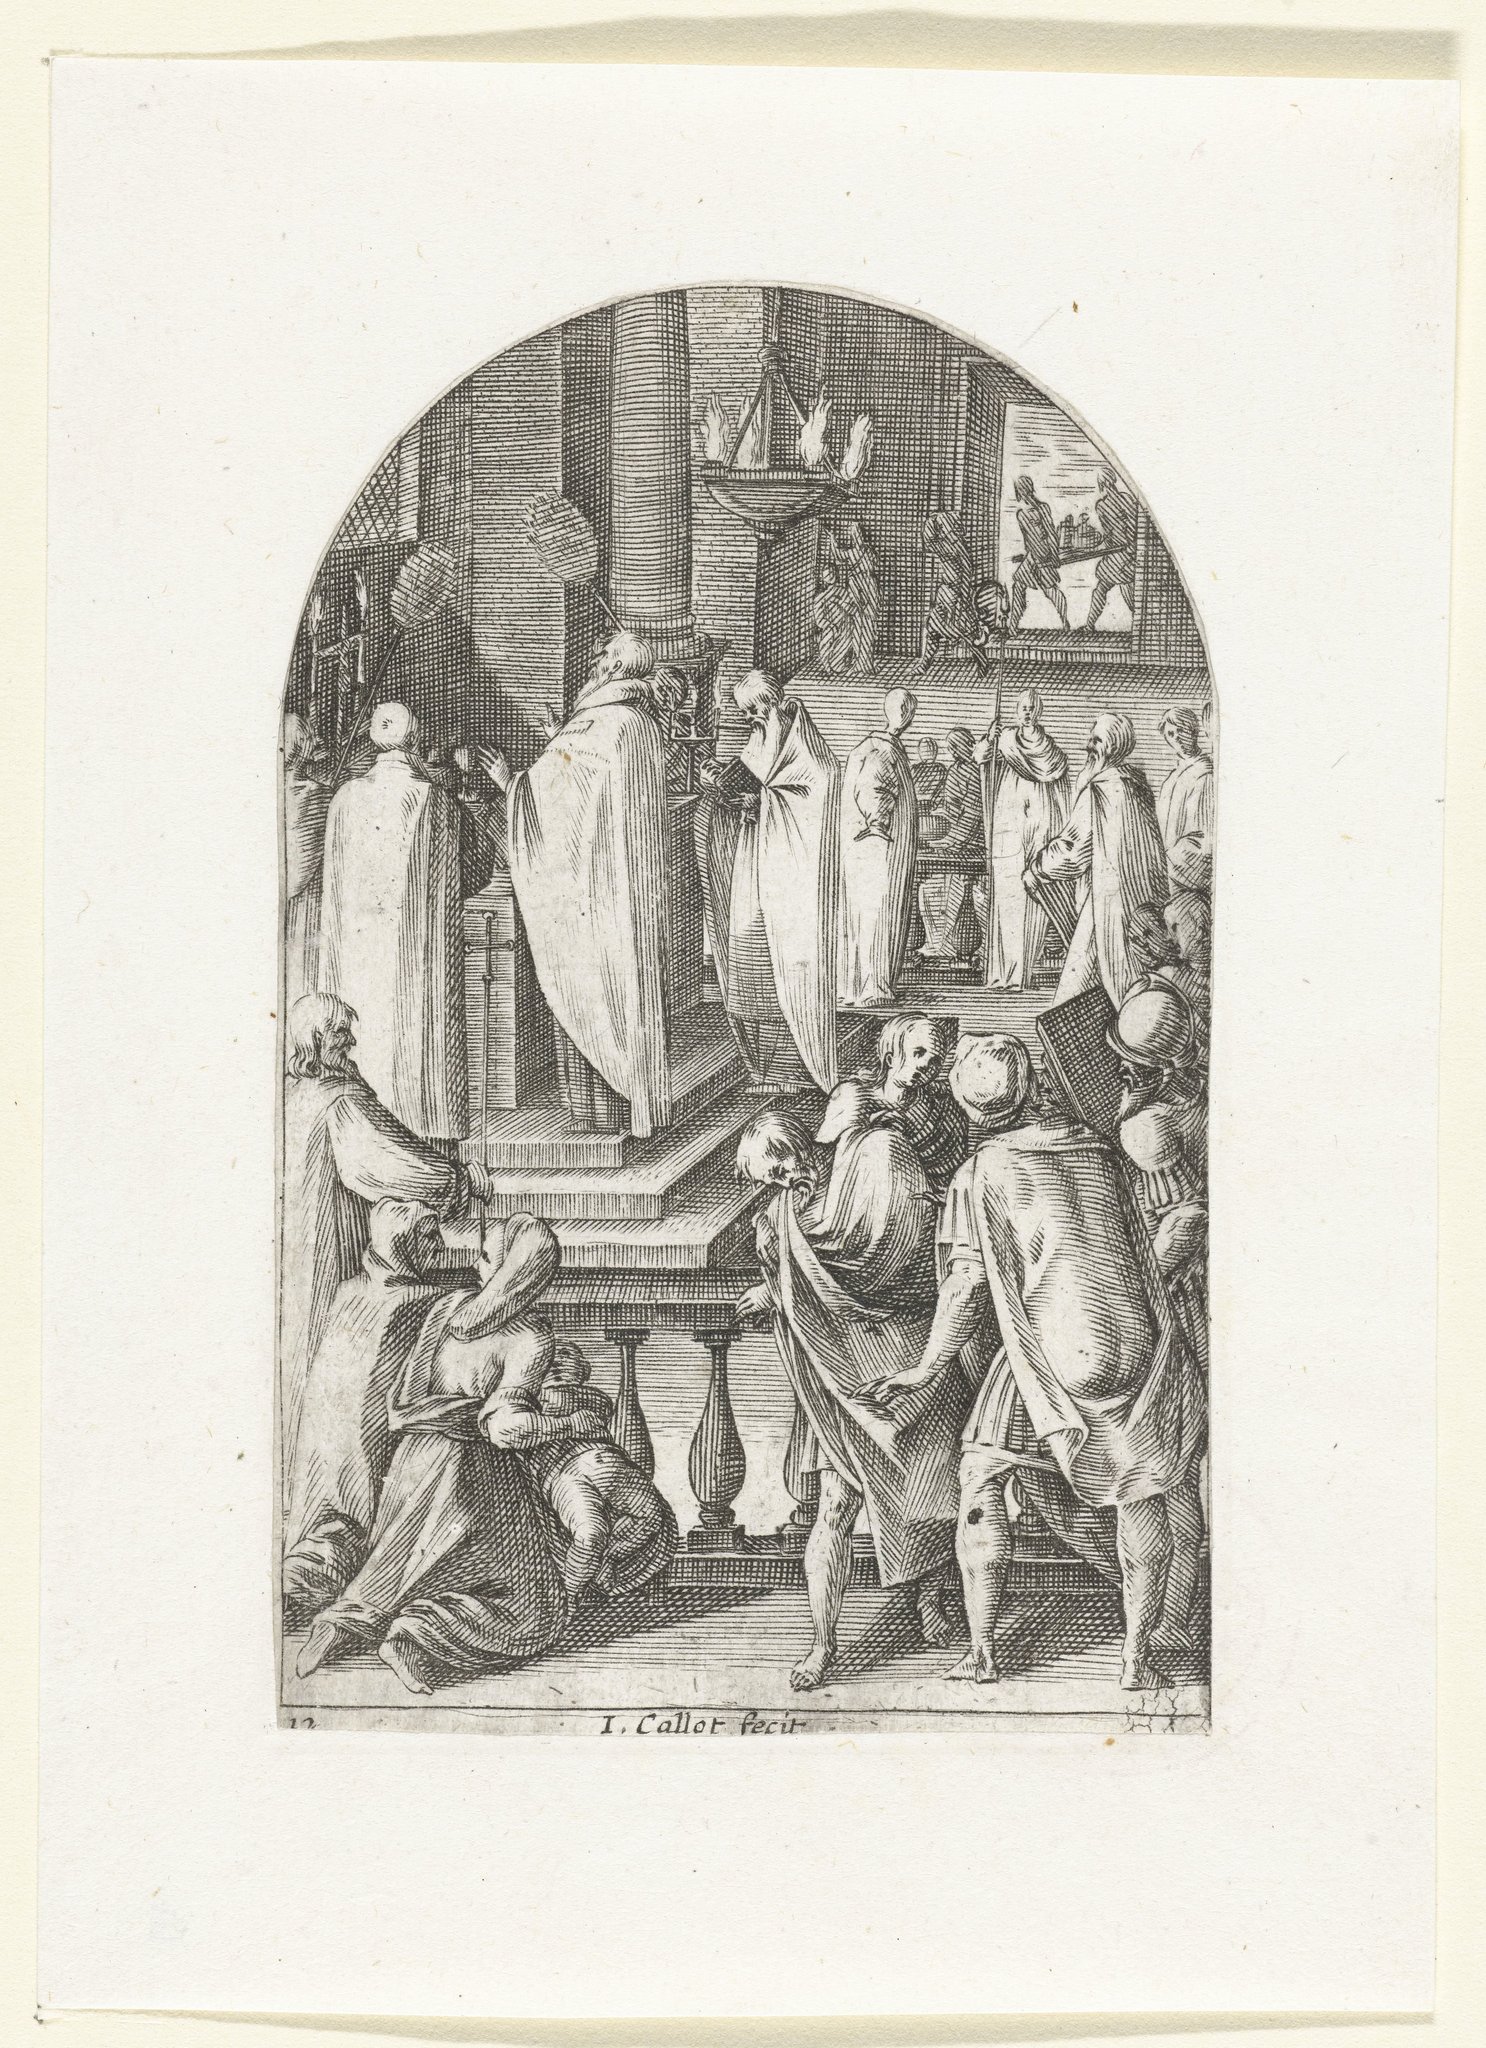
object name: print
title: De viering van de mis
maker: jacques callot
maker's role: draughtsman, print maker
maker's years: 1592-1635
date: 1608-1611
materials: paper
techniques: engraving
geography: rome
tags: the mass of st. basil: emperor valens faints, the mass of st. clement: theodora, wife of the heathen sisinnius present; sisinnius, who is spying, is struck blind, holy mass (divine service, especially of roman catholic church)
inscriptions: collector's mark: Lugt 240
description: Een priester (Heilige Basilius of Clemens?) staat voor een altaar in een kerk. Om hem heen een aantal toehoorders, onder wie een vrouw met een kind en een soldaat. Deze prent is onderdeel van (de tweede staat van) een serie van 29 voorstellingen van schilderijen en sculpturen in kerken te Rome, genummerd 1-16 en 1-13. (De eerste staat van deze serie, waarin de prenten ongenummerd zijn, behelst ook een titelprent.